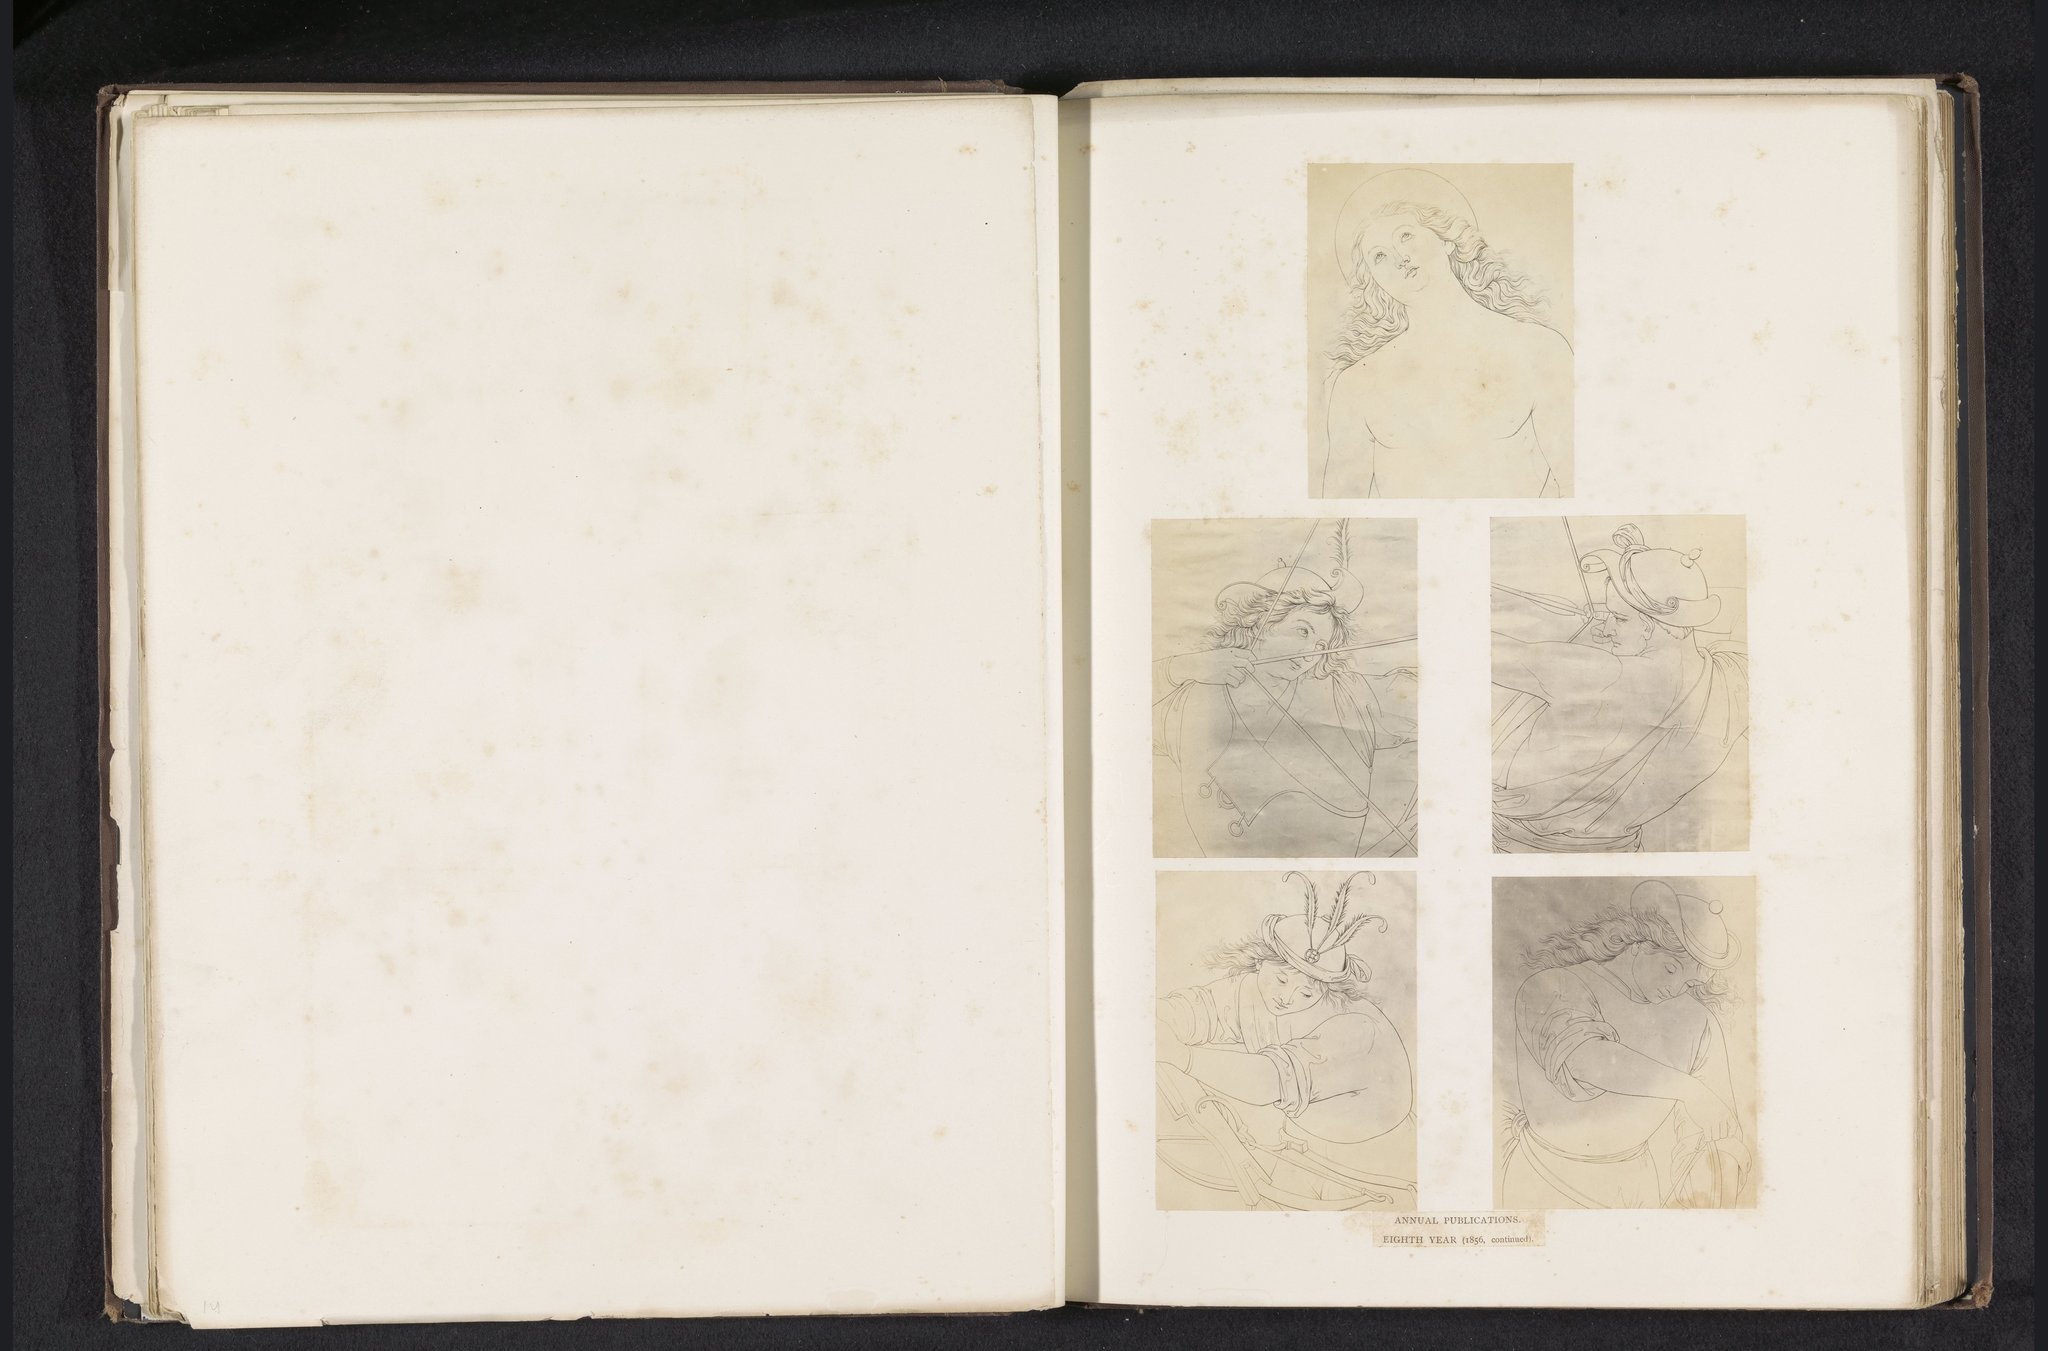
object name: page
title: Vijf fotoreproducties van een publicatie door de Arundel Society met tekeningen van de heilige Sebastiaan naar Perugino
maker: Anonymous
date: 1859-1869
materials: photographic support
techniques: albumen print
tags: martyrdom, suffering, misfortune, death of st. sebastian, book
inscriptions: inscription: ‘Annual publications. Eighth year (1856, continued).’